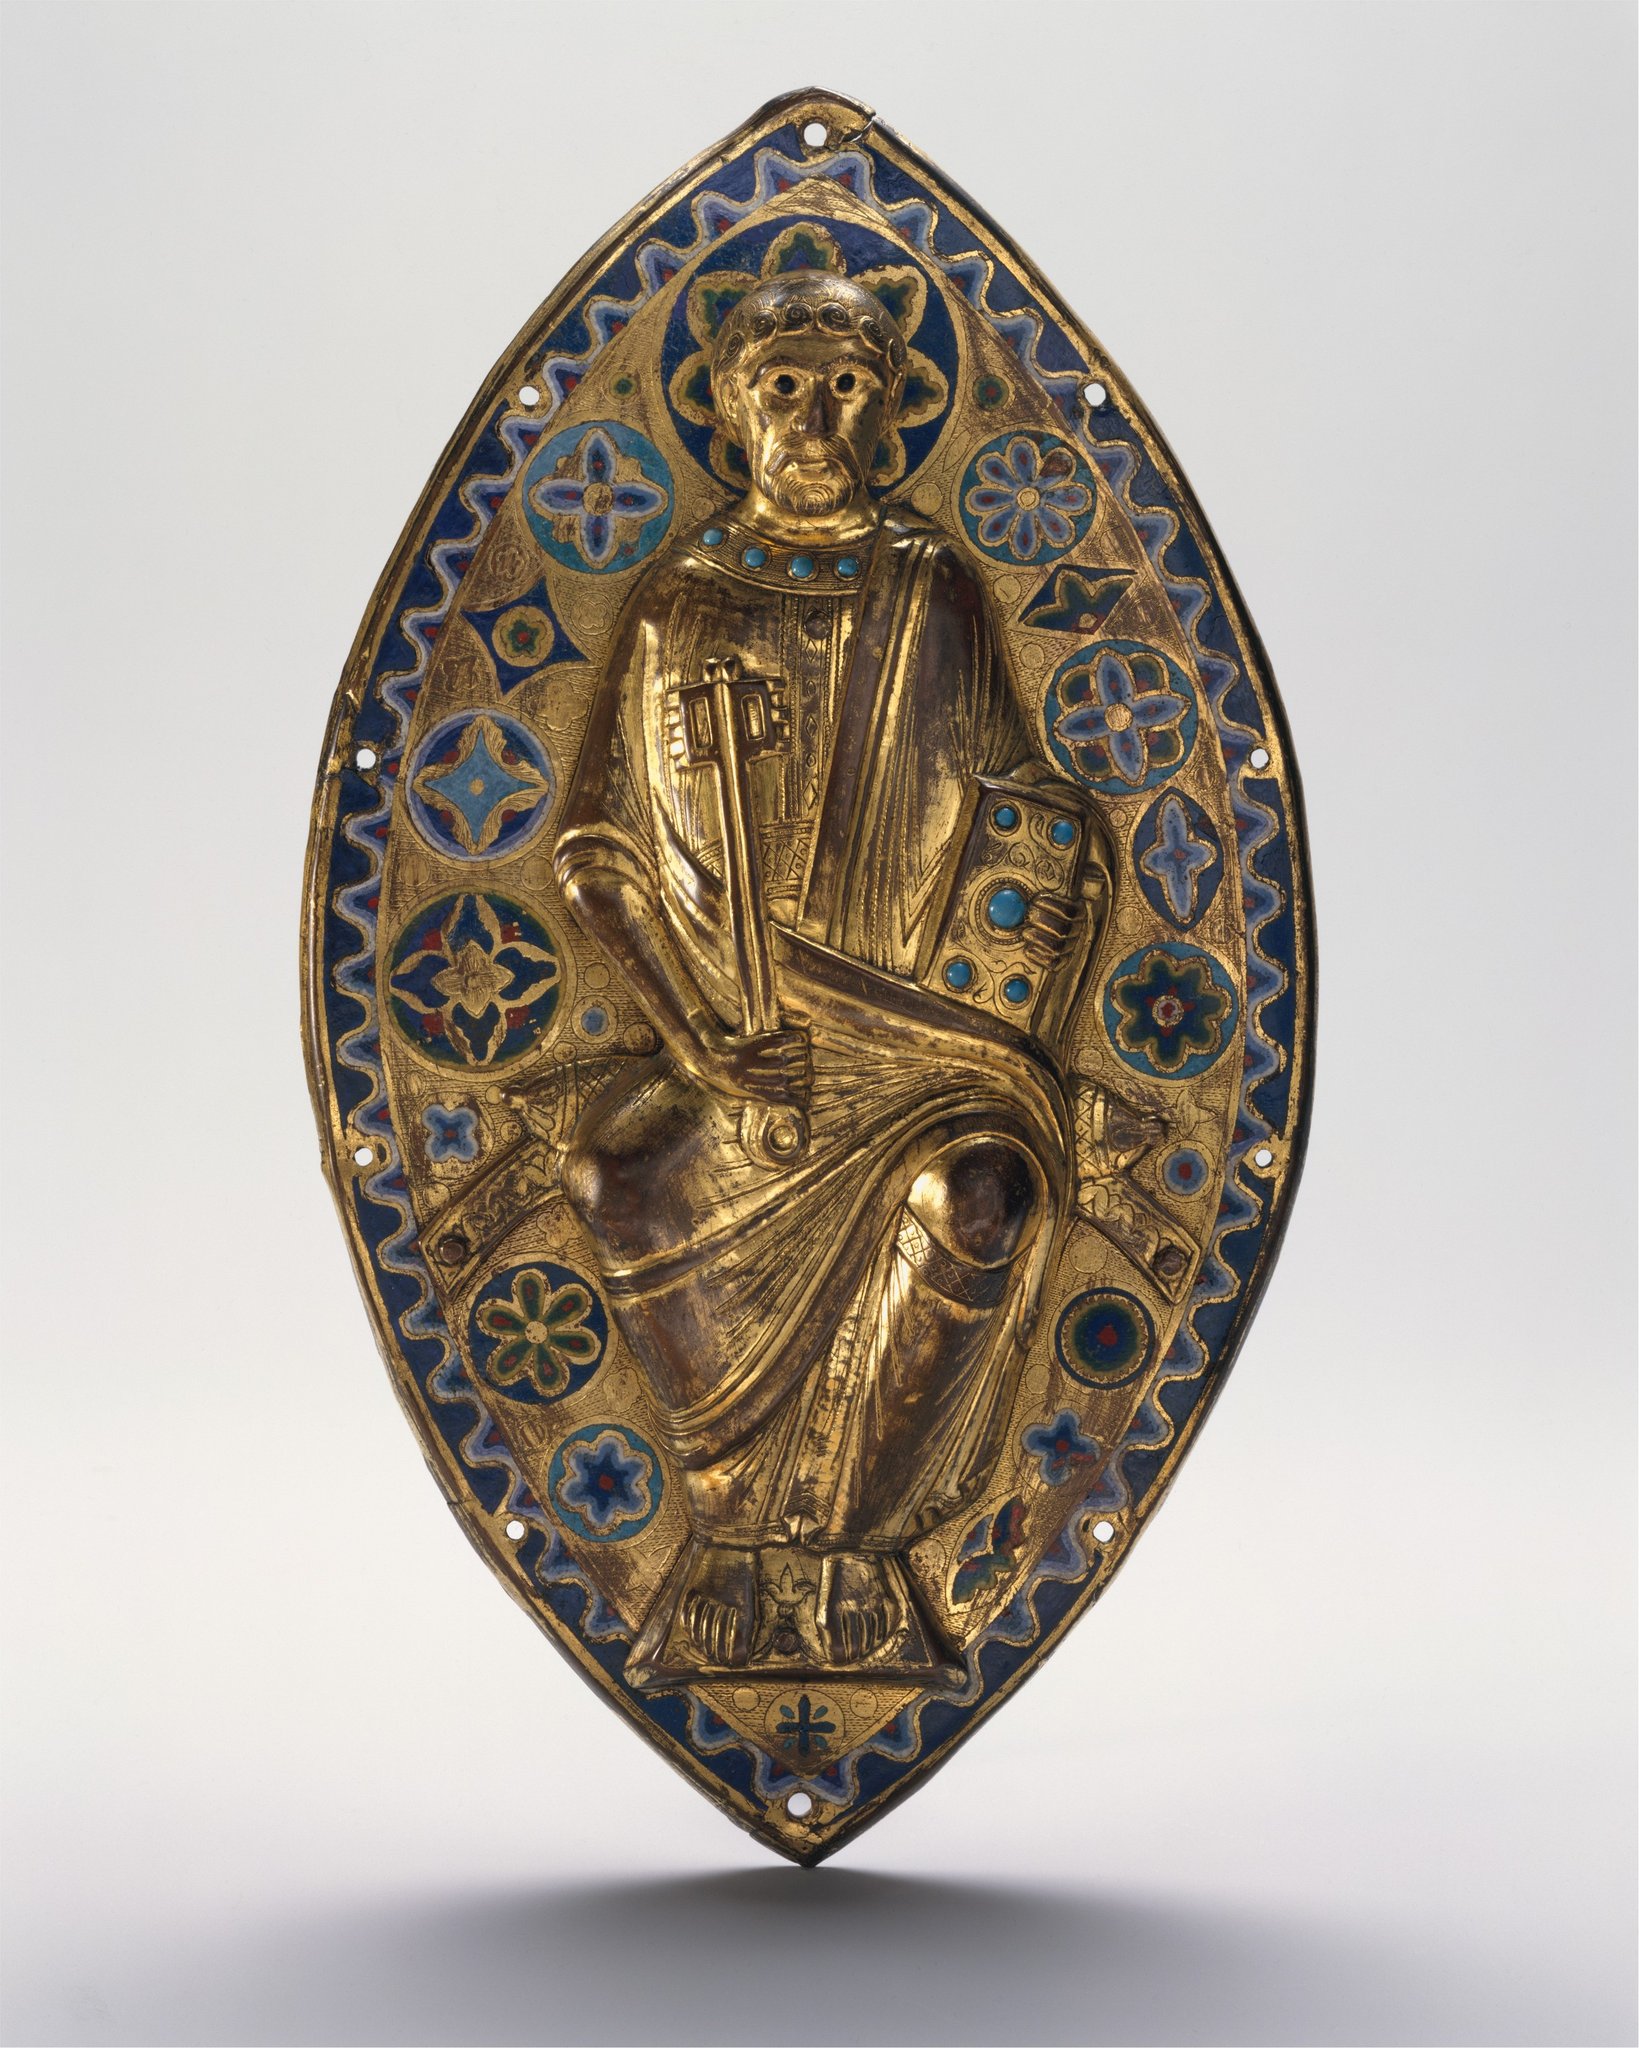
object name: plaque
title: Plaque with Saint Peter in Glory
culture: french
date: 1185-1200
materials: copper, enamel, gilt, glass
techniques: appliqué, enamel, chasing, engraving, repoussé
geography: france